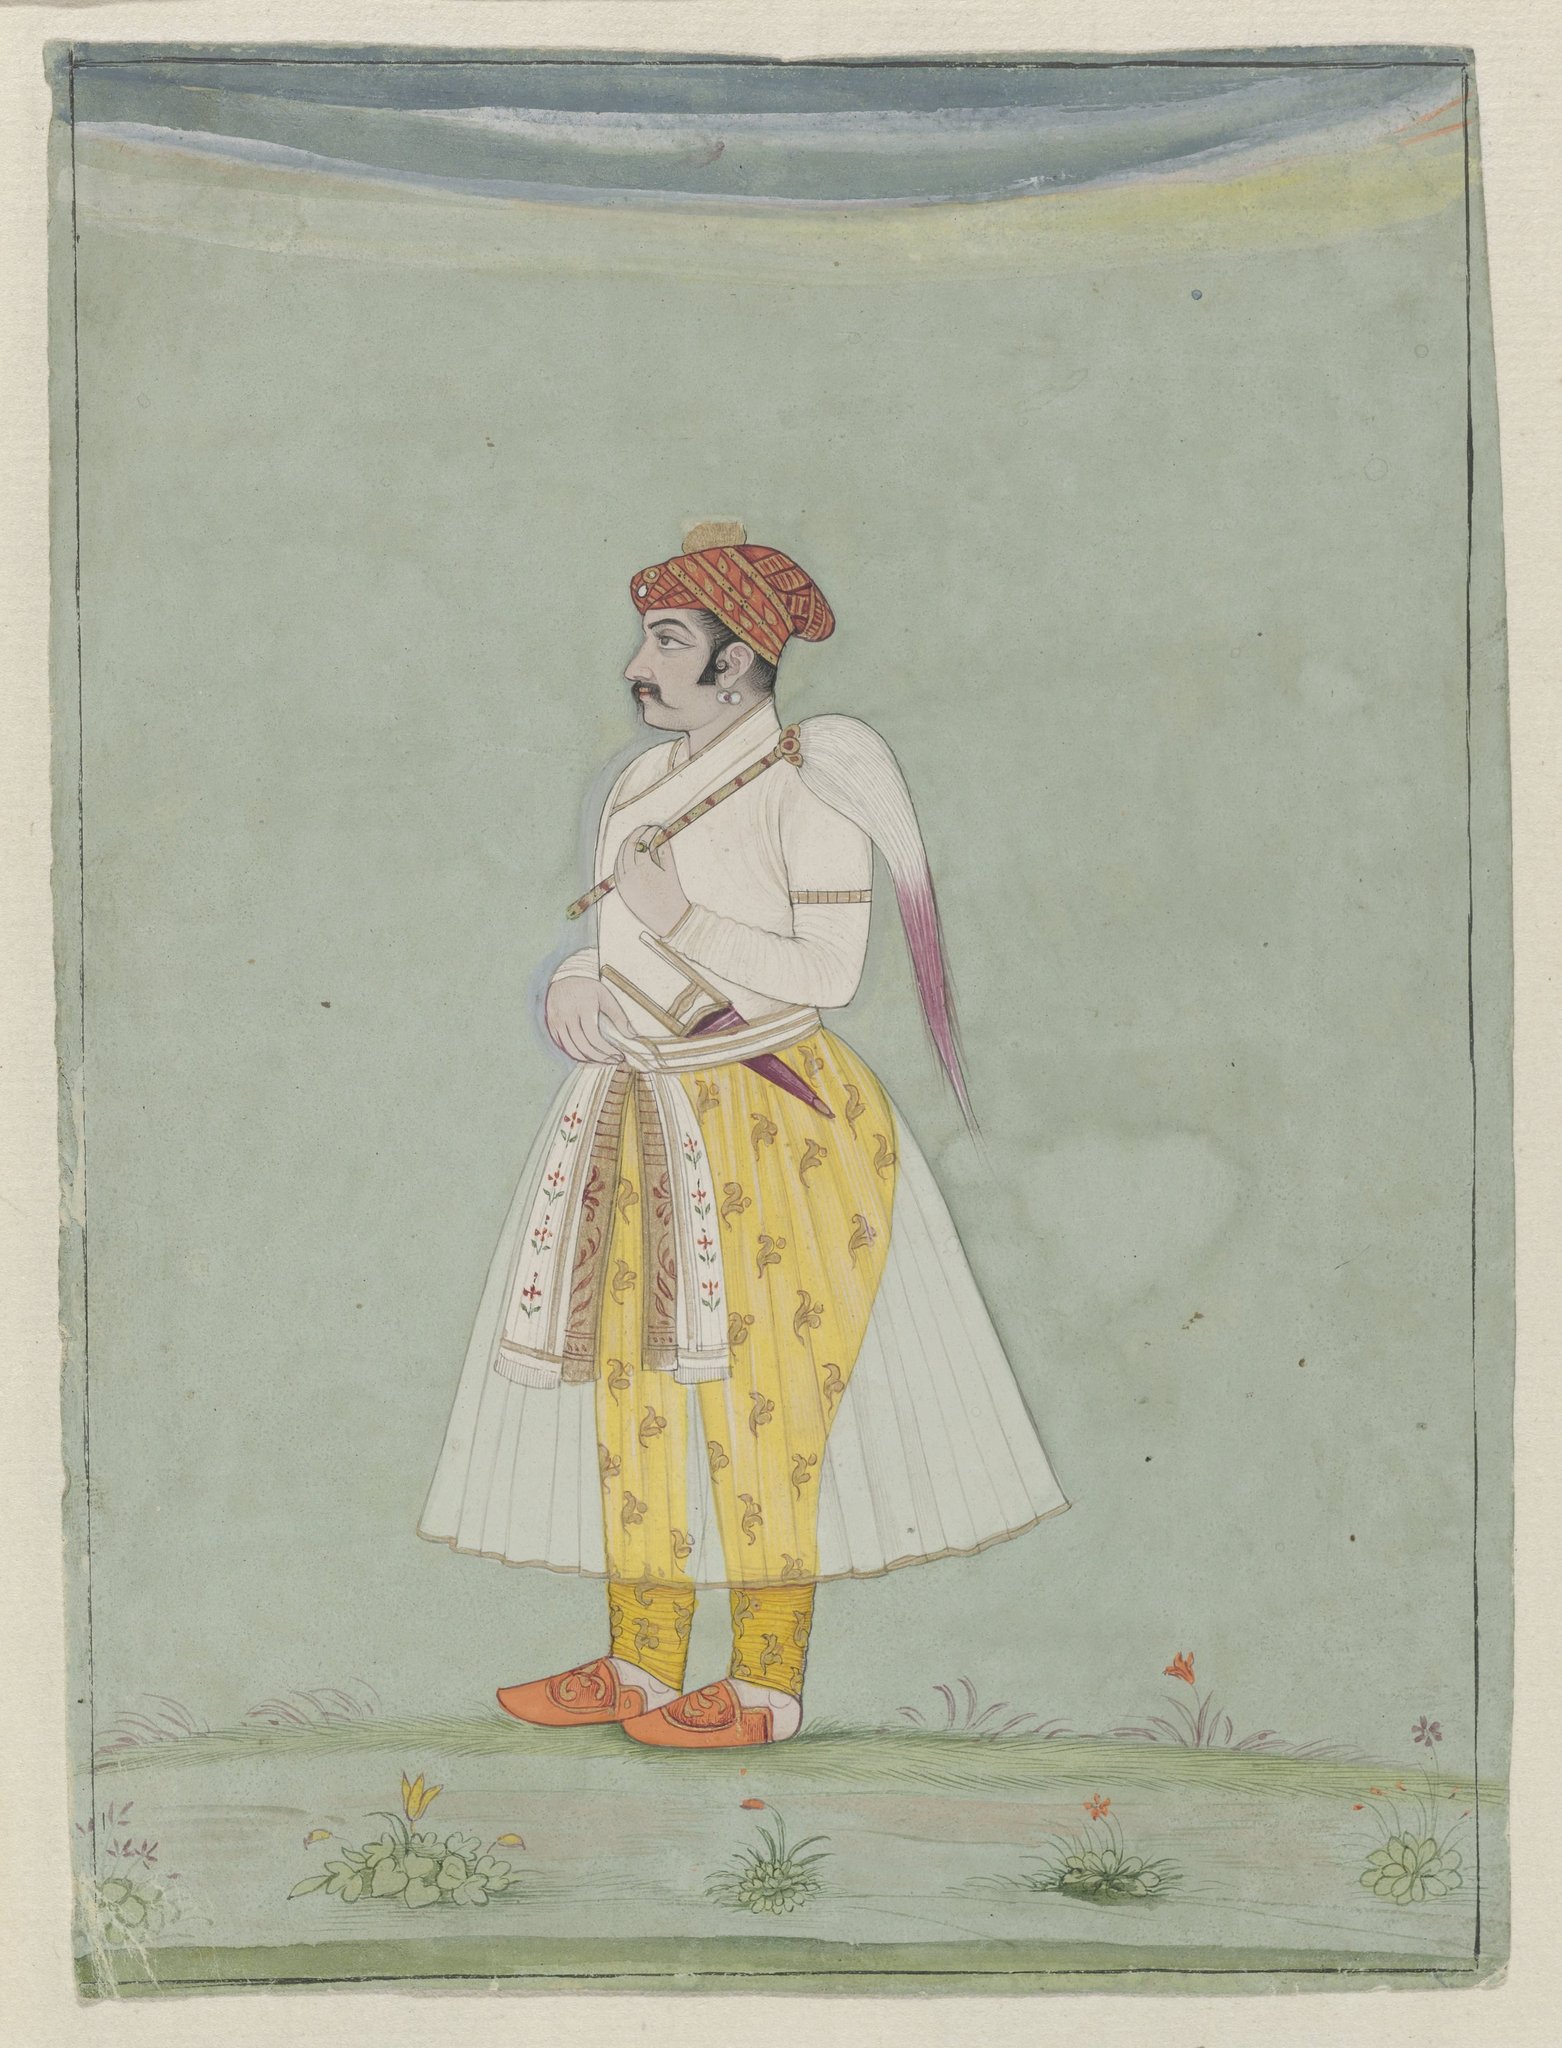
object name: drawing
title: Den grootvader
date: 1675-1725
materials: paper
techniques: drawing, writing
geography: deccan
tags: adrianus canter visscher, family of the sovereign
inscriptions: caption: ‘Den grootvader van den gewesen Sounalsgouverneur / Mien Sjabel chan’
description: Tekening uit het manuscript van de VOC dienaar Adrianus Canter Visscher met achterin achtentwintig Indiase miniaturen en twee kaarten van plaatsen aan de Coromandelkust. De tekst bestaat uit twee delen: een geschiedenis van het Mogolrijk en de VOC-vestigingen aan de Coromandelkust; daarna volgt een advies aan de Heren XVII over de economische situatie van de VOC in de Coromandel.